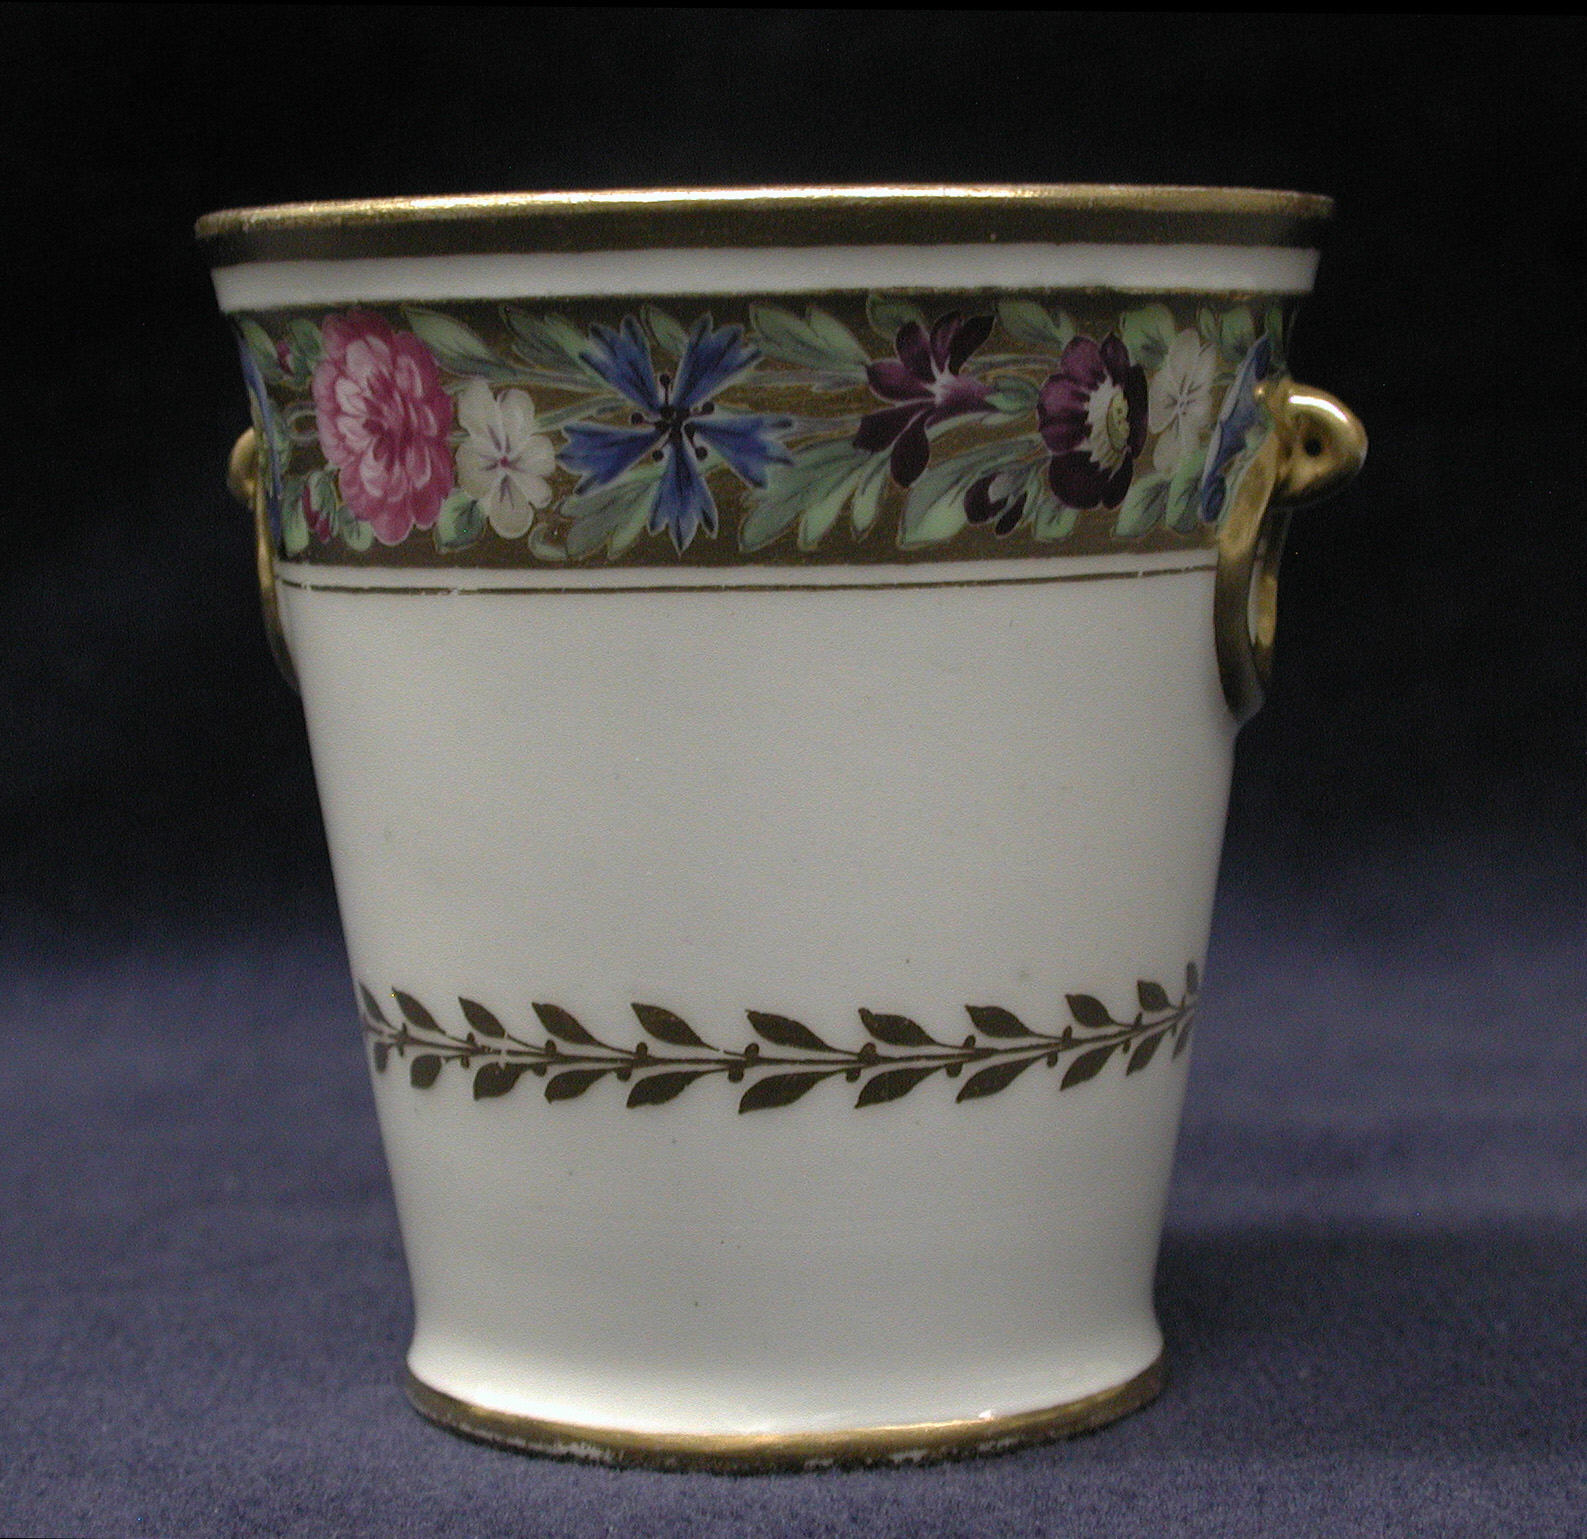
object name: custard cup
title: Seven custard cups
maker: imperial porcelain manufactory, st. petersburg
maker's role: manufactory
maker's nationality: russian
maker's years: 1744-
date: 1796-1825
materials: hard paste porcelain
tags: flowers